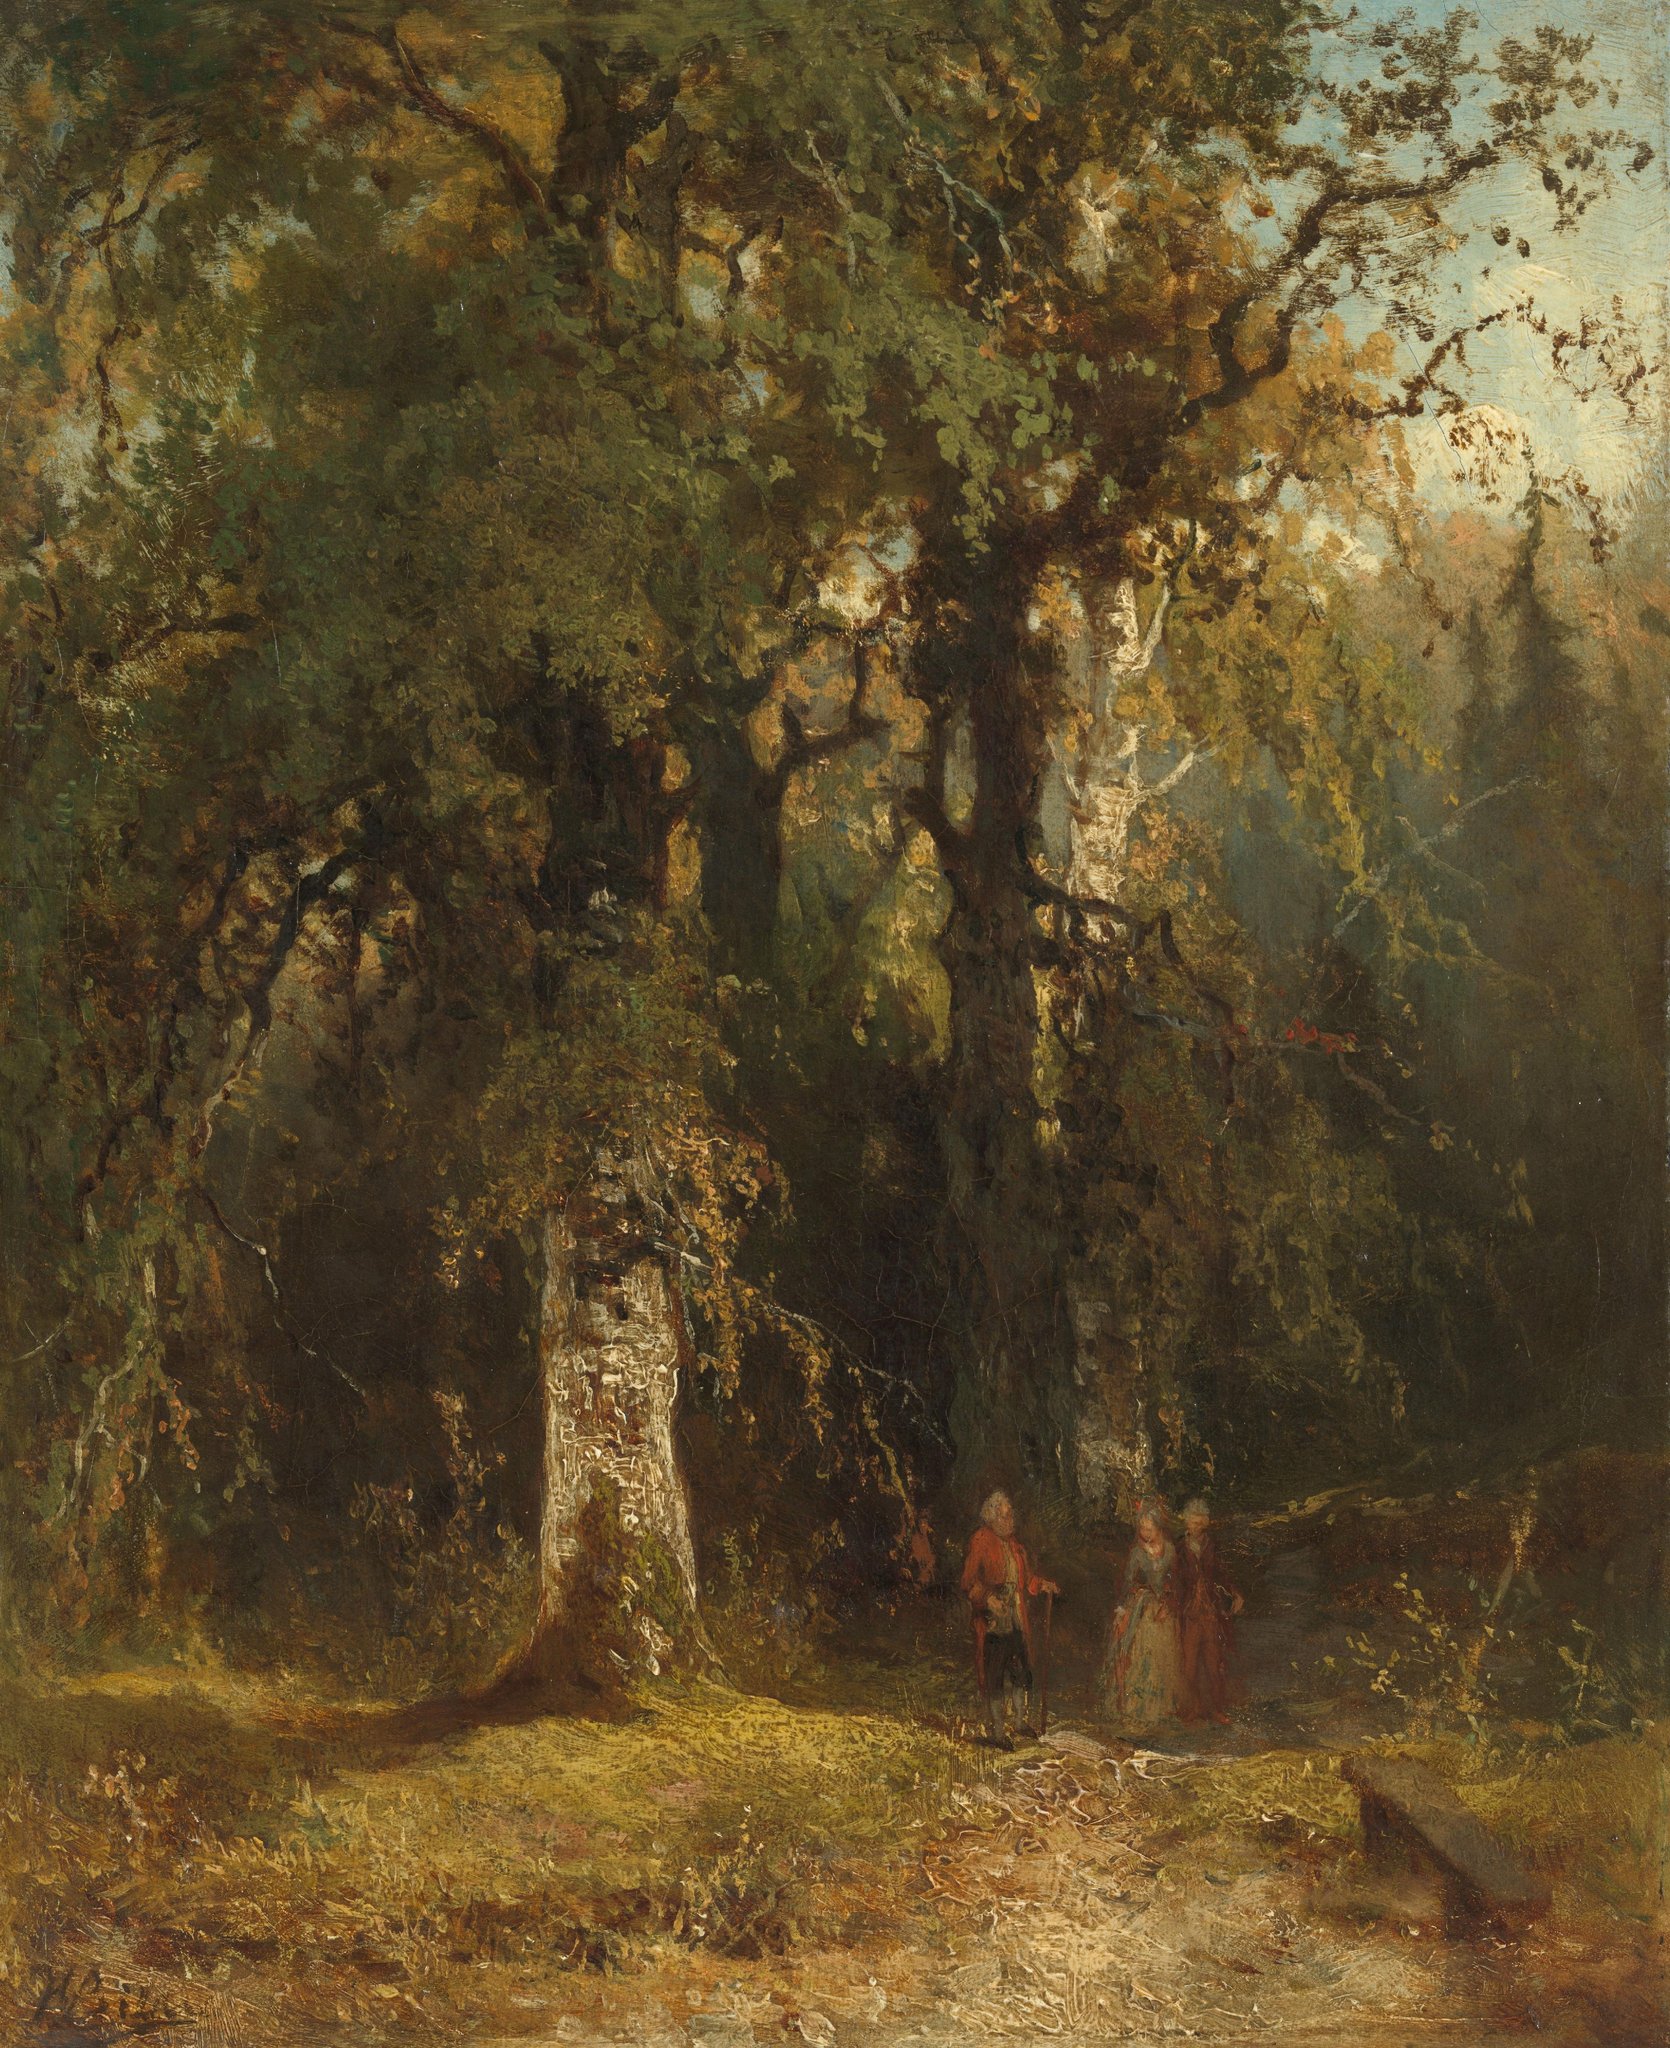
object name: painting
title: View in the Woods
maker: johannes warnardus bilders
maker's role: painter, print maker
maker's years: 1811-1890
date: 1850-1890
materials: canvas, oil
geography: netherlands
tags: forest path or lane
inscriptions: signature: ‘JWBilders’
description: Boslandschap met drie figuren wandelend op een pad.